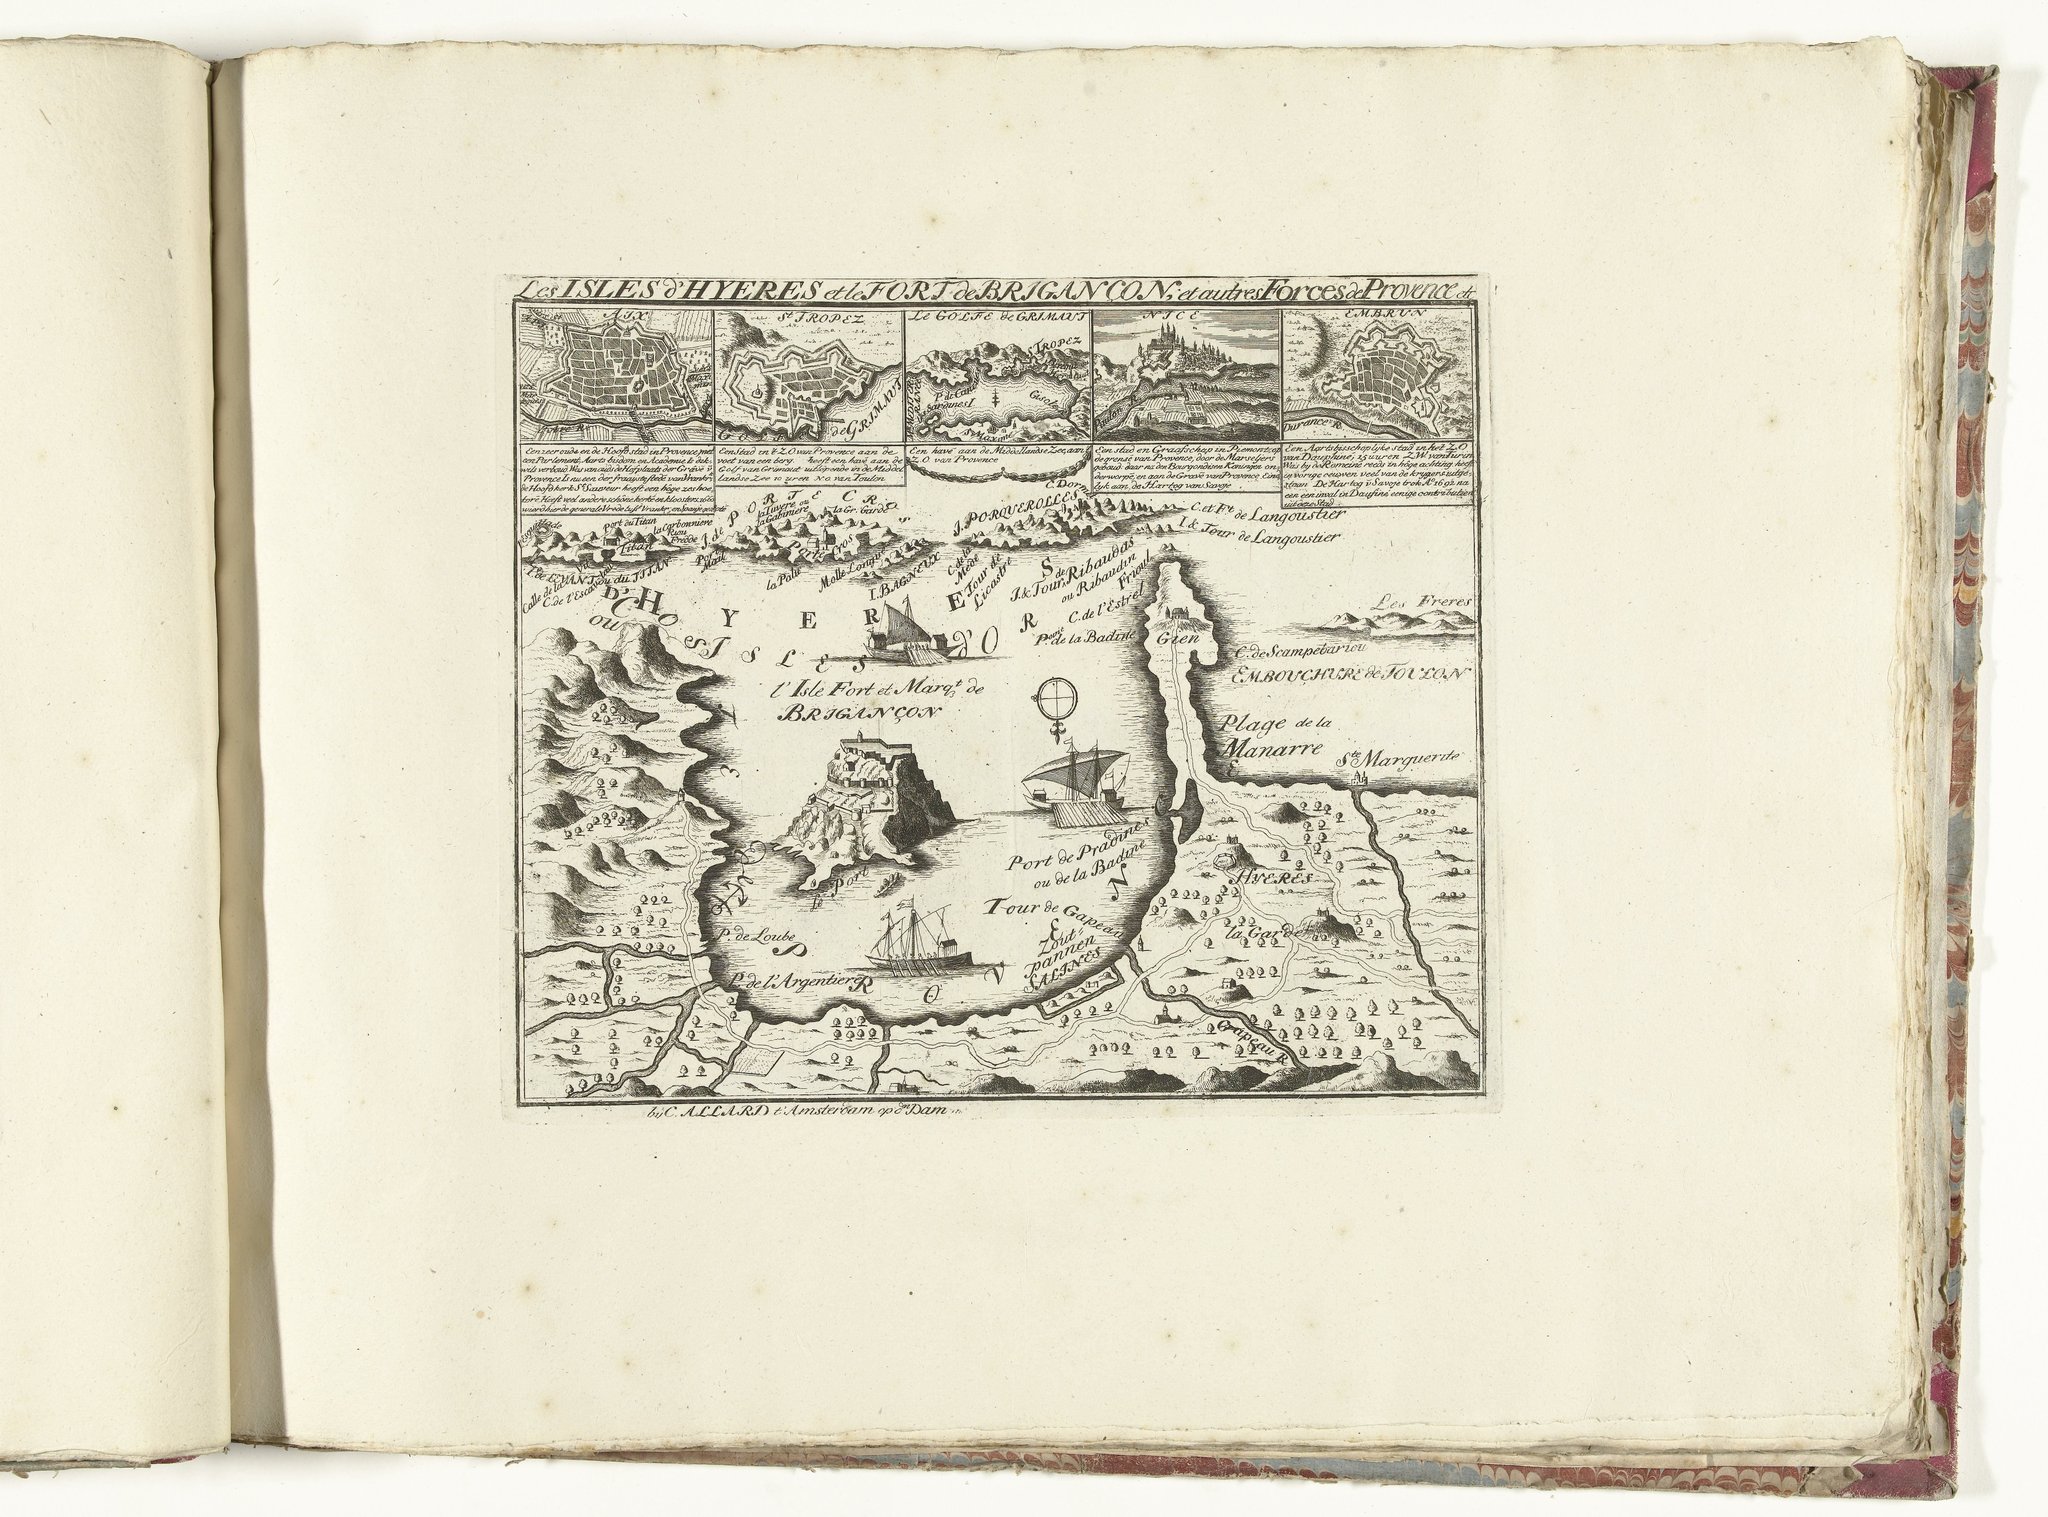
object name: album leaf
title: Les Principales Forteresses & Villes Fortes, d'Espagne, de France, d'Italie, de Savoië, d'Allemagne & des Païs-Bas (...) / Naaukeurige Afbeeldingen der Voornaamste Sterke Steden en Vestingen in Spanjen, Vrankryk, Italien, Savoyen, Duytsland en Nederlanden (...)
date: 1701-1714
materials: paper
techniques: etching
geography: france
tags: maps of separate countries or regions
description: Gekopieerd naar de Franse prenten in: Nicolas de Fer, Les forces de l'Europe, ou description des principales villes, avec leurs fortifications : dessignées par les meilleurs ingenieurs, particulierement celles ... de la France, dont les plans ont esté levez par M. de Vauban, Nicolas de Fer, Parijs 1693-1696, of andere voorbeelden.